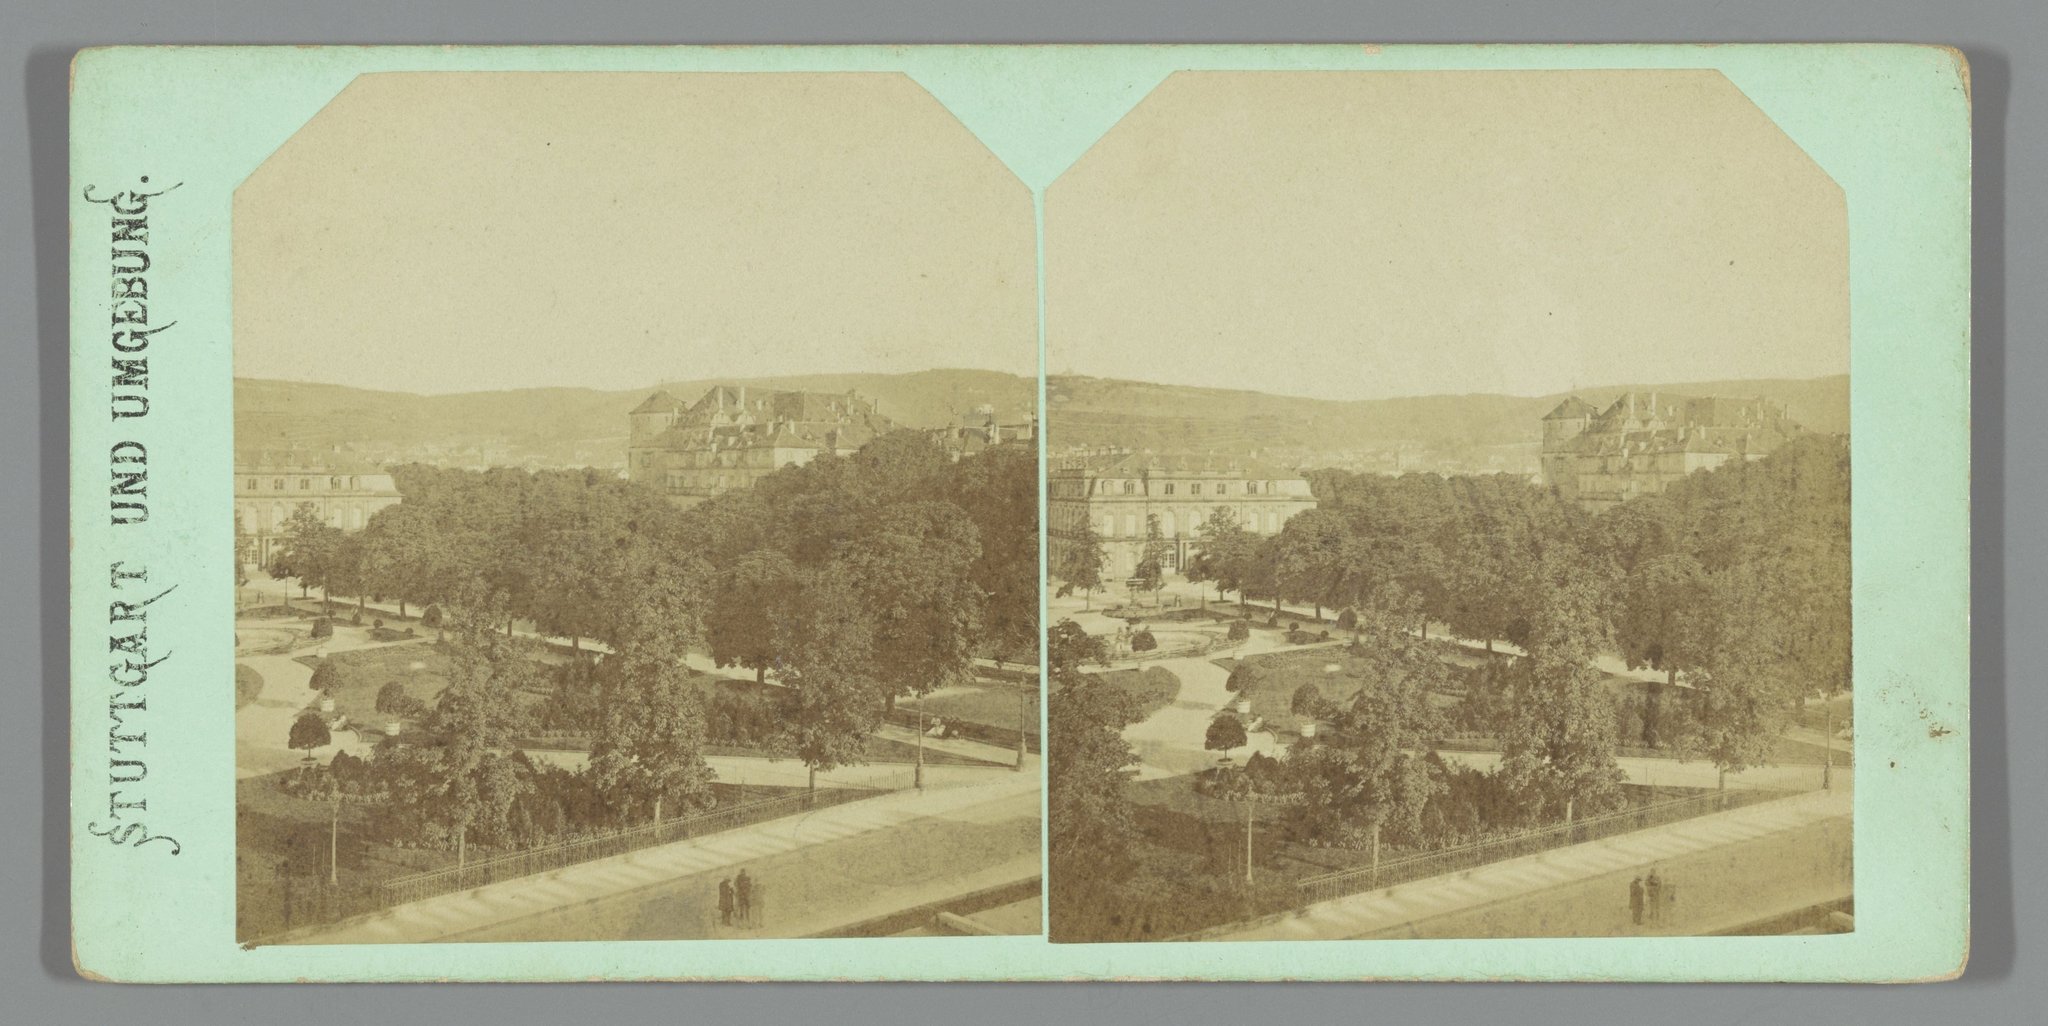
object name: stereograph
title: Stuttgart und Umgebung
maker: Anonymous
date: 1860-1880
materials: cardboard, photographic support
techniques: albumen print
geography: stuttgart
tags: palace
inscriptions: number: ‘2.’